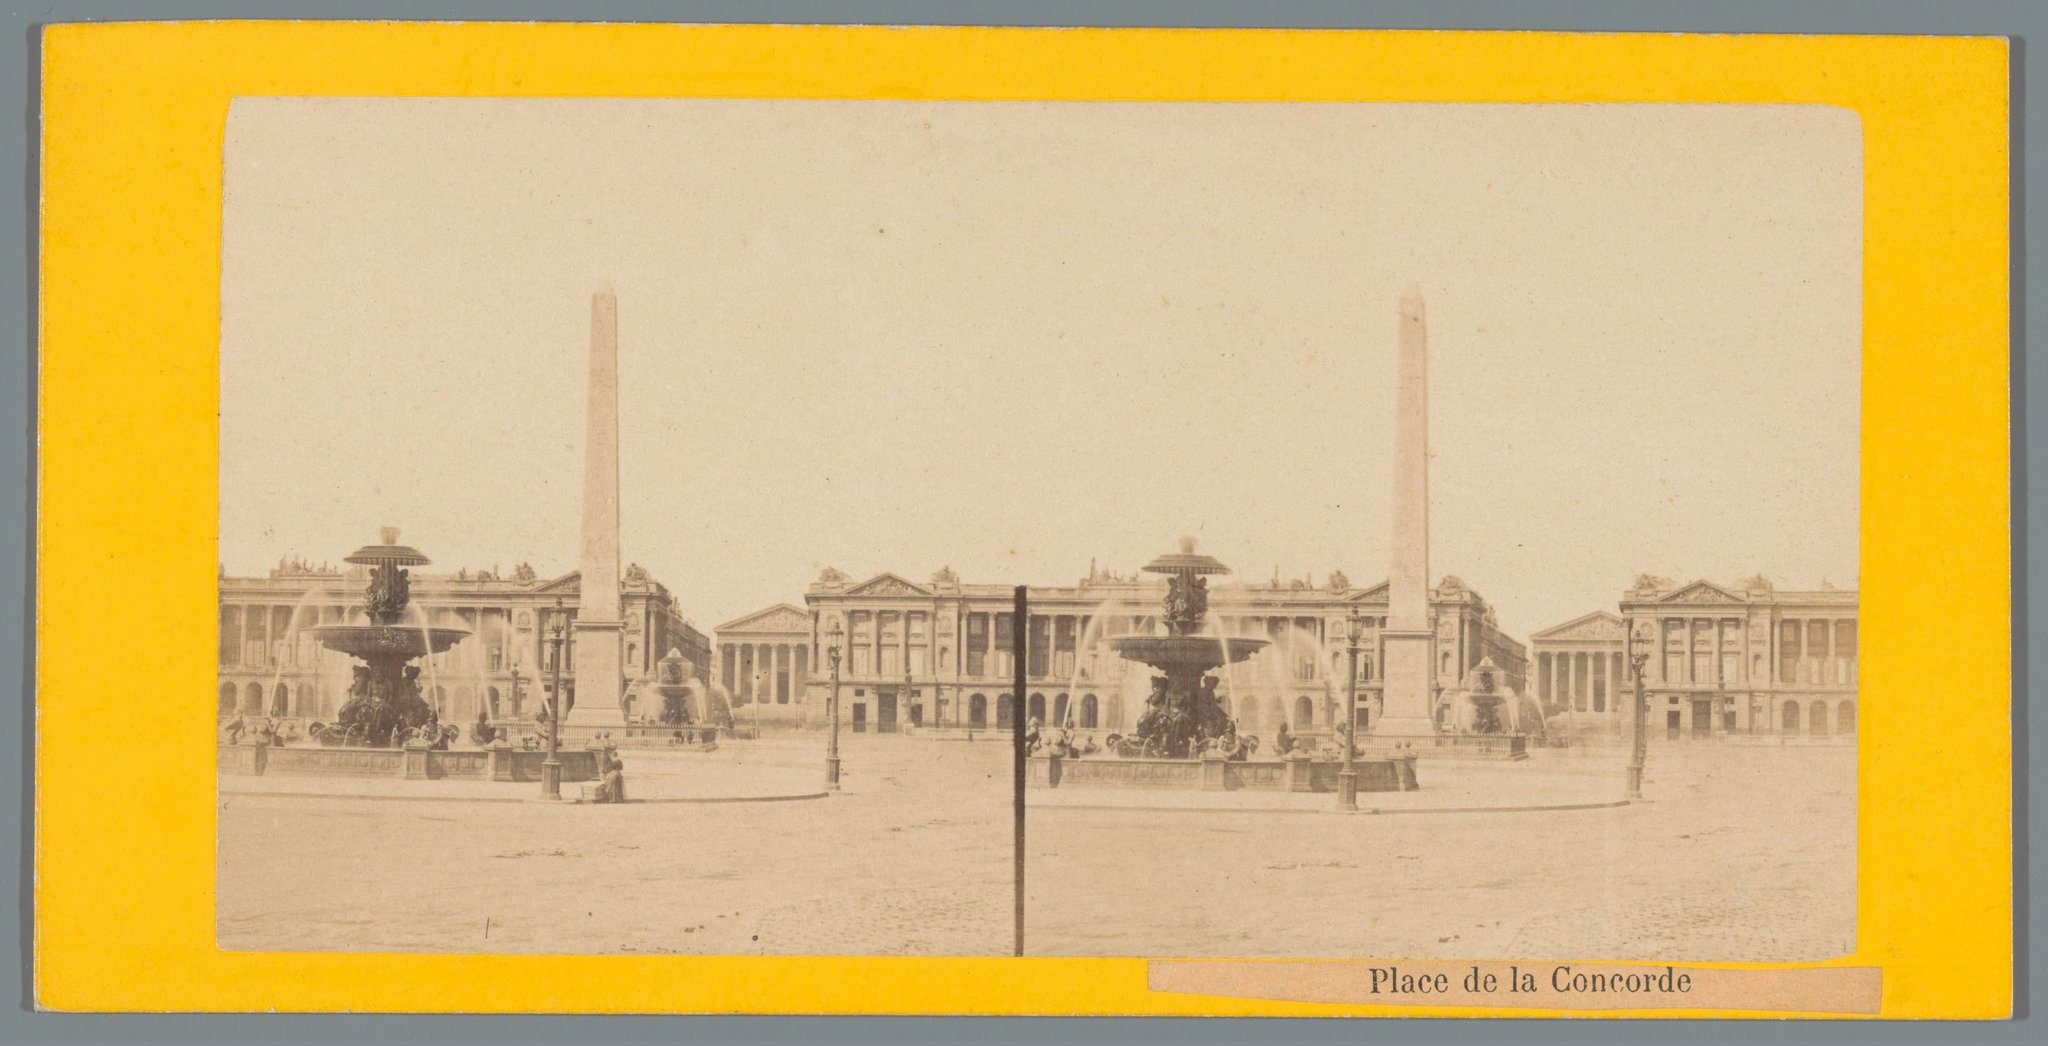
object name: stereograph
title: Gezicht op Place de la Concorde in Parijs met een fontein en de Luxor obelisk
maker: Anonymous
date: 1850-1880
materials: cardboard, photographic support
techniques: albumen print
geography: place de la concorde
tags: square, place, circus, etc., monument, statue, ornamental fountain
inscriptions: number: ‘n 4’